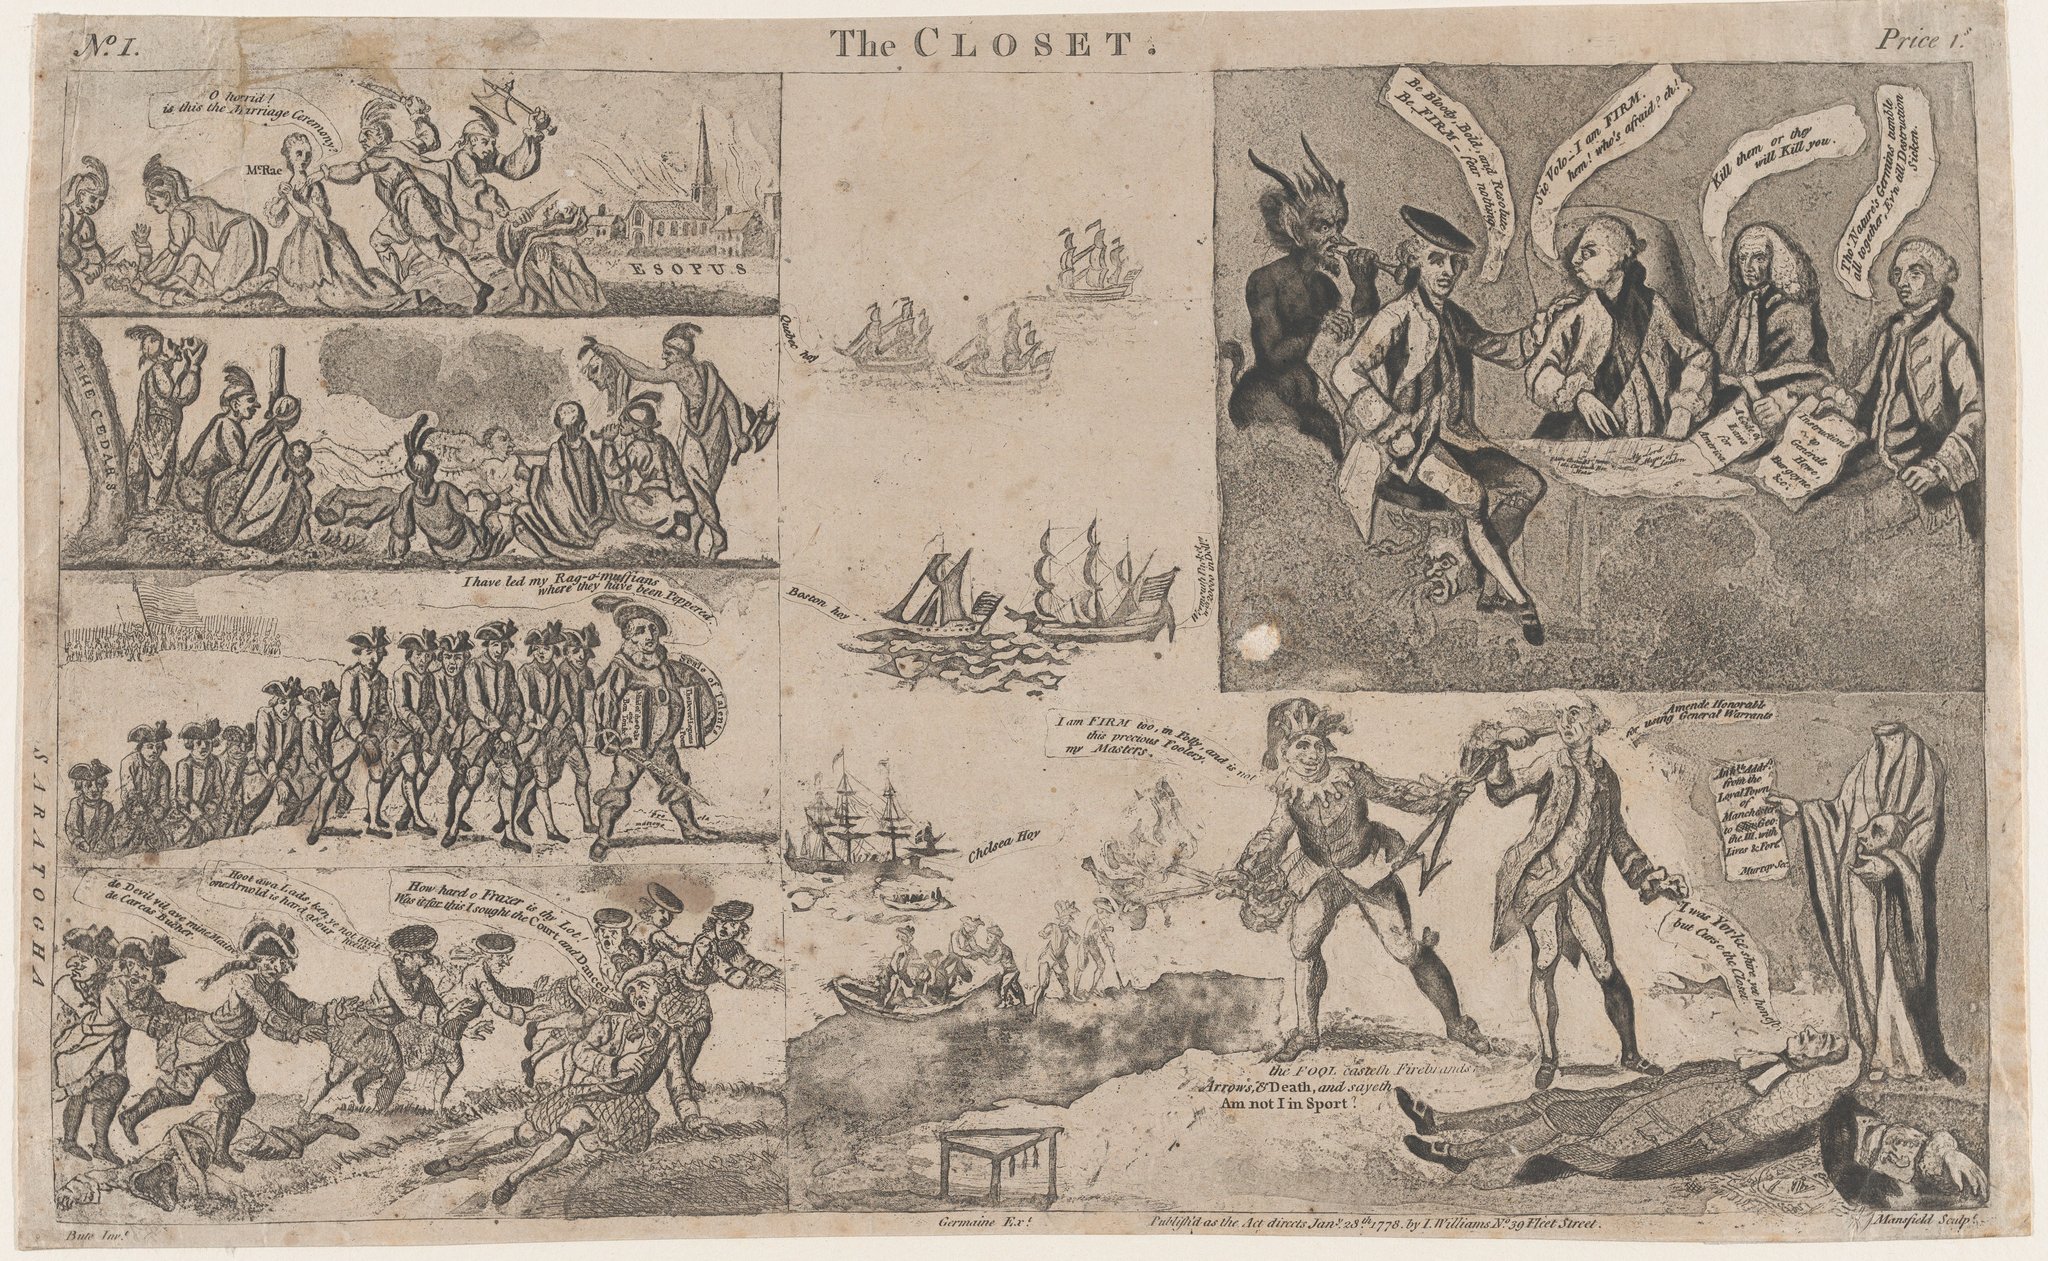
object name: print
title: The Closet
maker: anonymous, british, 18th century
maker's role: artist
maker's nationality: british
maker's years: 1700-1800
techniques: aquatint, etching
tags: satire,soldiers,american revolution,ships,politics